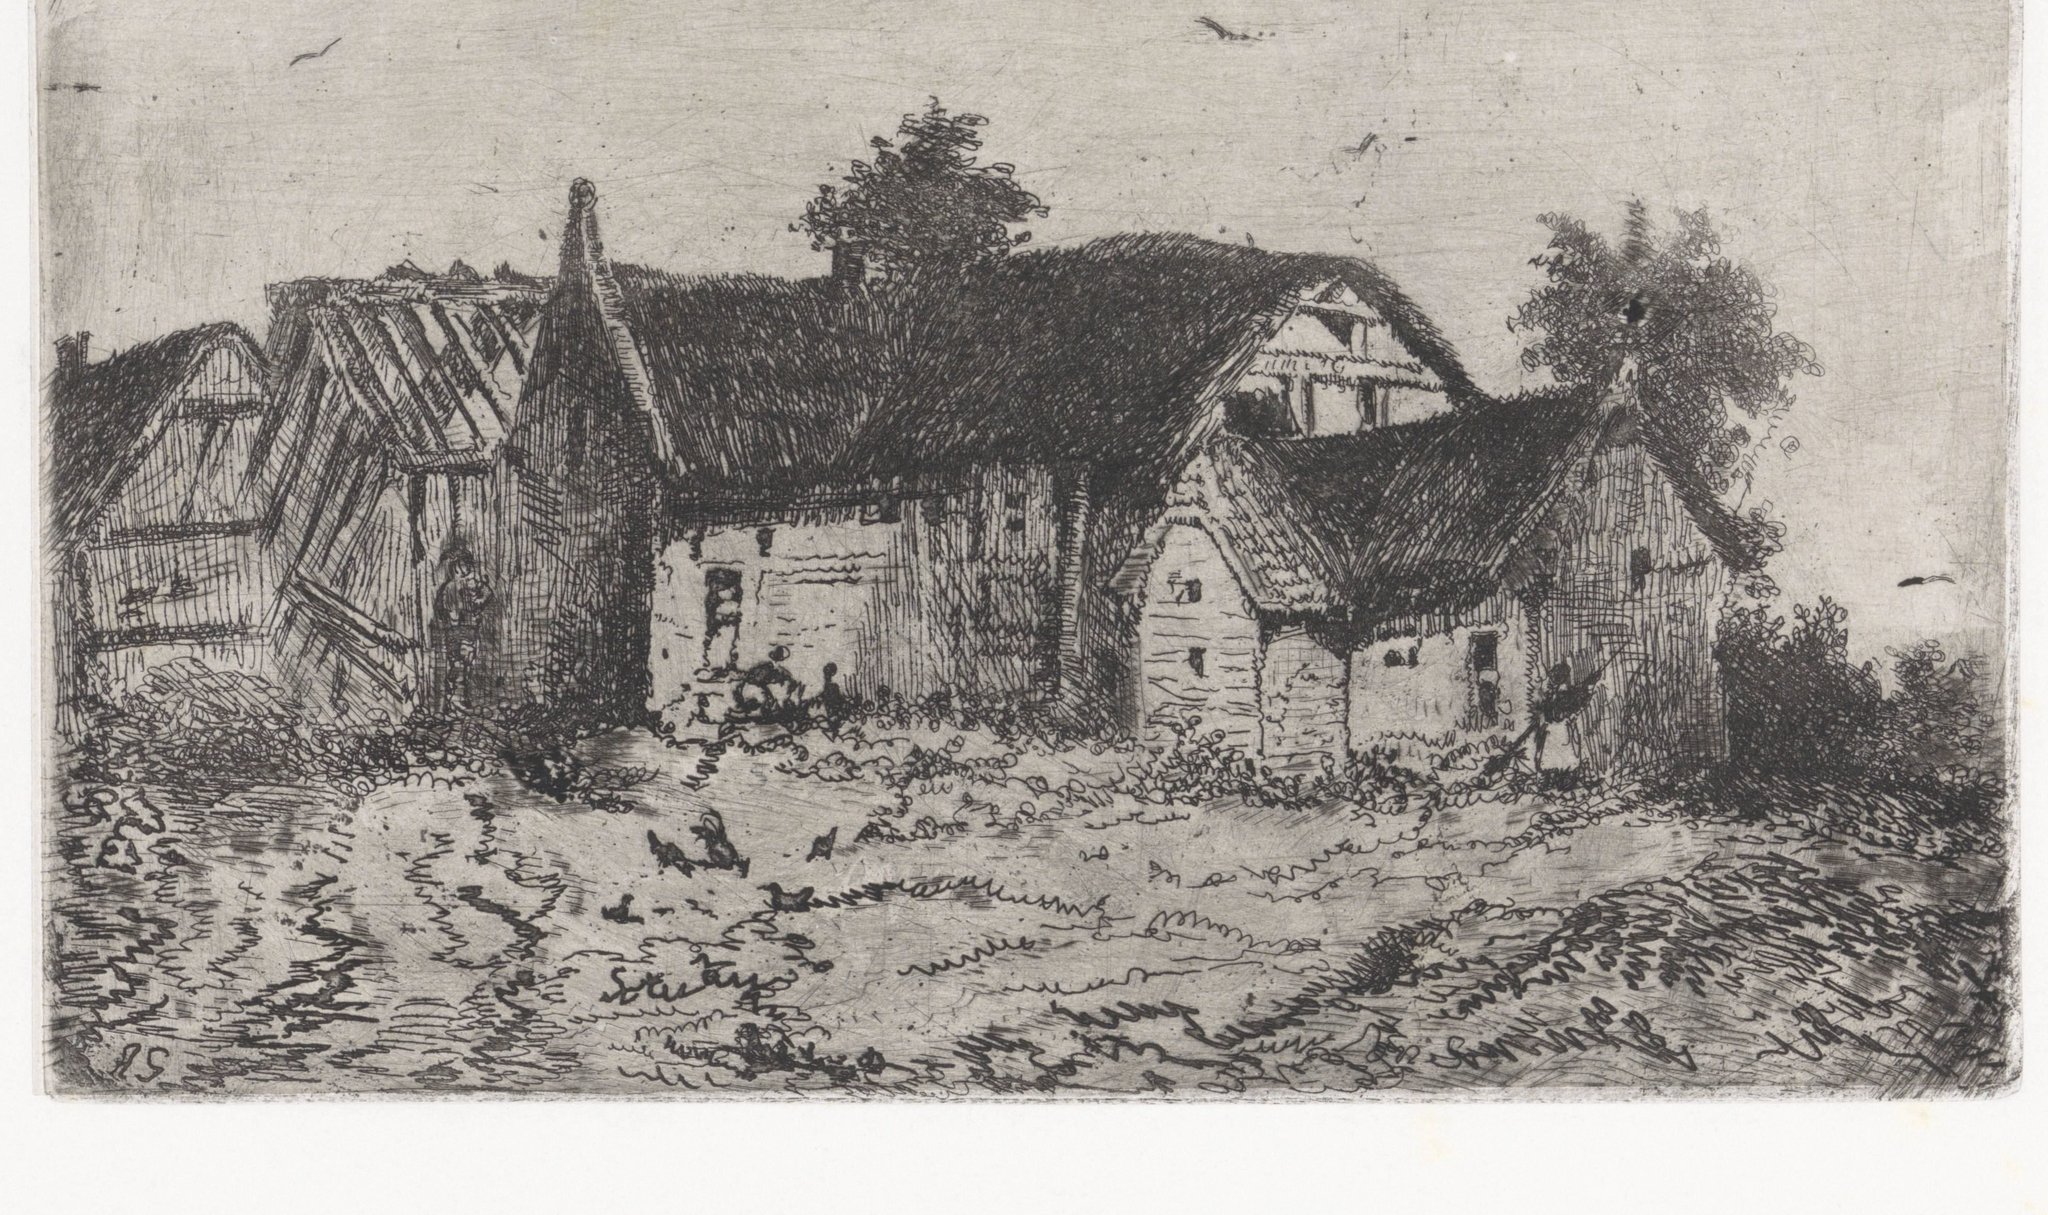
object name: print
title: Groep rietgedekte huizen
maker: arnoud schaepkens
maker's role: print maker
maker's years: 1816-1904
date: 1855-1904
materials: paper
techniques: drypoint, etching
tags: cottage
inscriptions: collector's mark: Lugt 2228